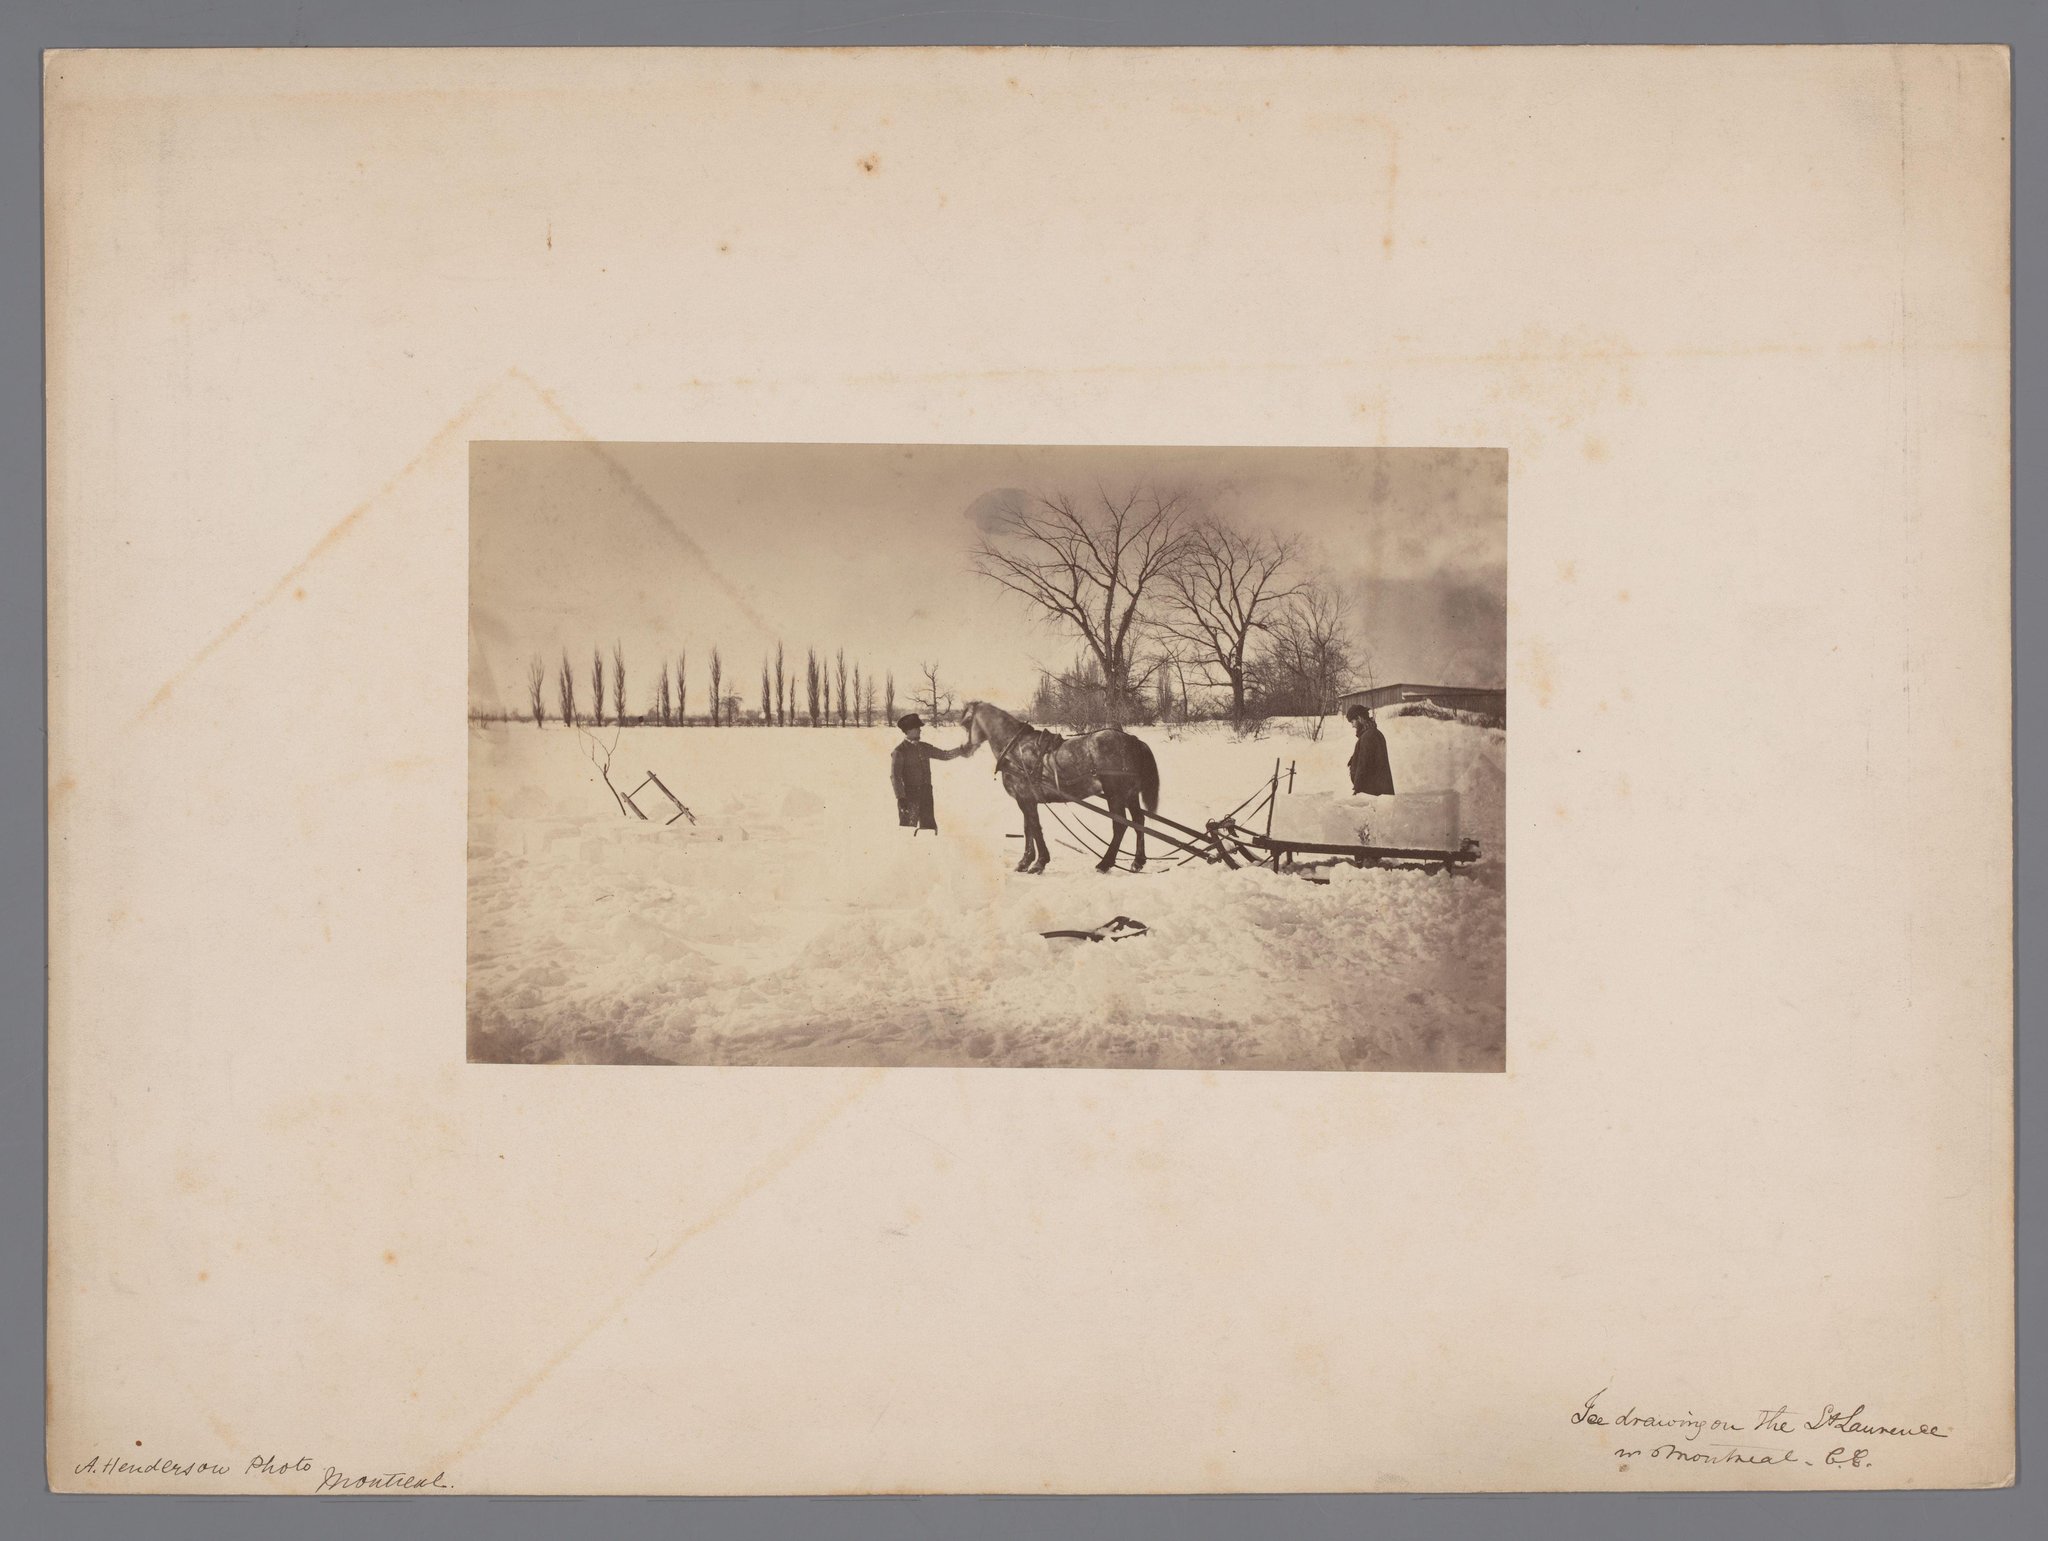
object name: photograph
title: IJs kruien op de rivier St. Lawrence, Montréal, Canada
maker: alexander henderson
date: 1870-1910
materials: cardboard, paper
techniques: albumen print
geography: montreal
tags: montreal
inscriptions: inscription: ‘A. Henderson Photo//Montreal’, inscription: ‘Ice drawing on the St. Lawrence//in Montreal, C.C. [?]’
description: IJs kruien op de rivier St. Lawrence, Montréal, Canada.